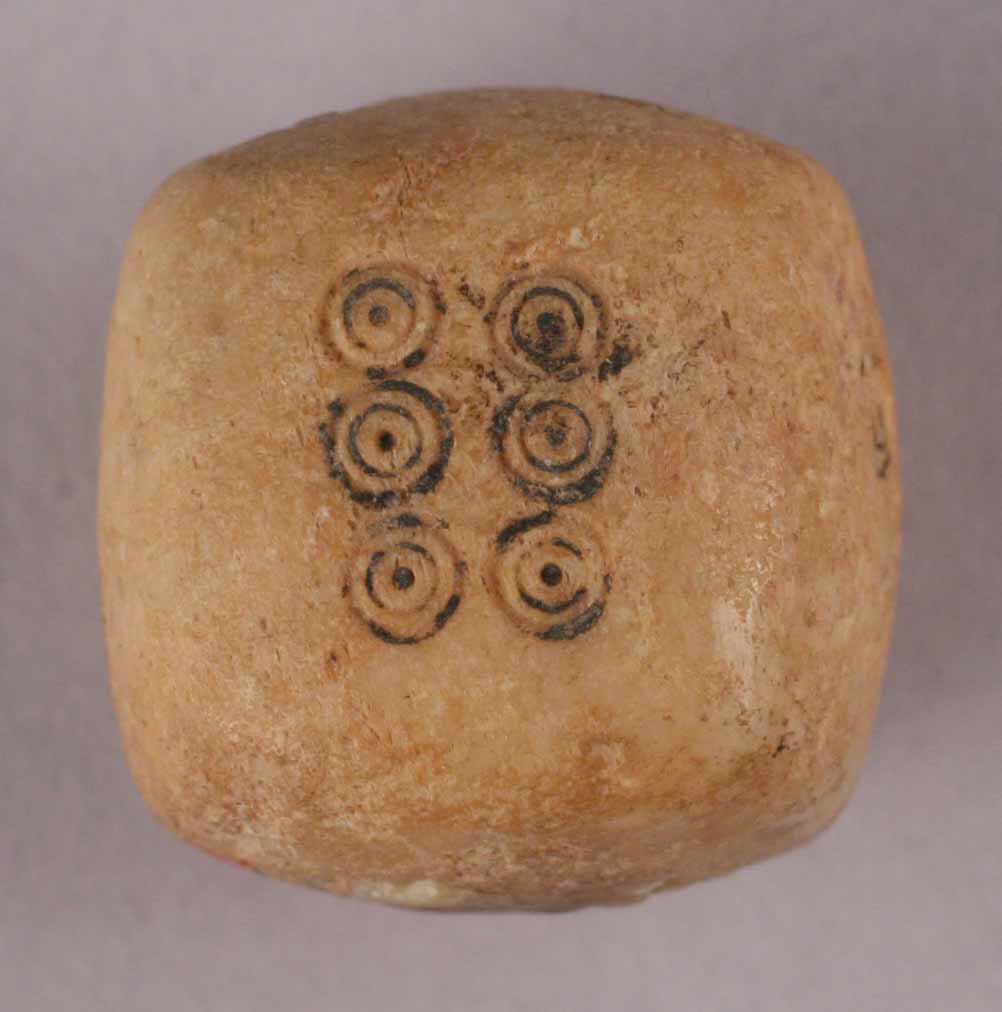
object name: dice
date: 801-1000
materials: bone, paint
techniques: incising, inlay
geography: iran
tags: dice